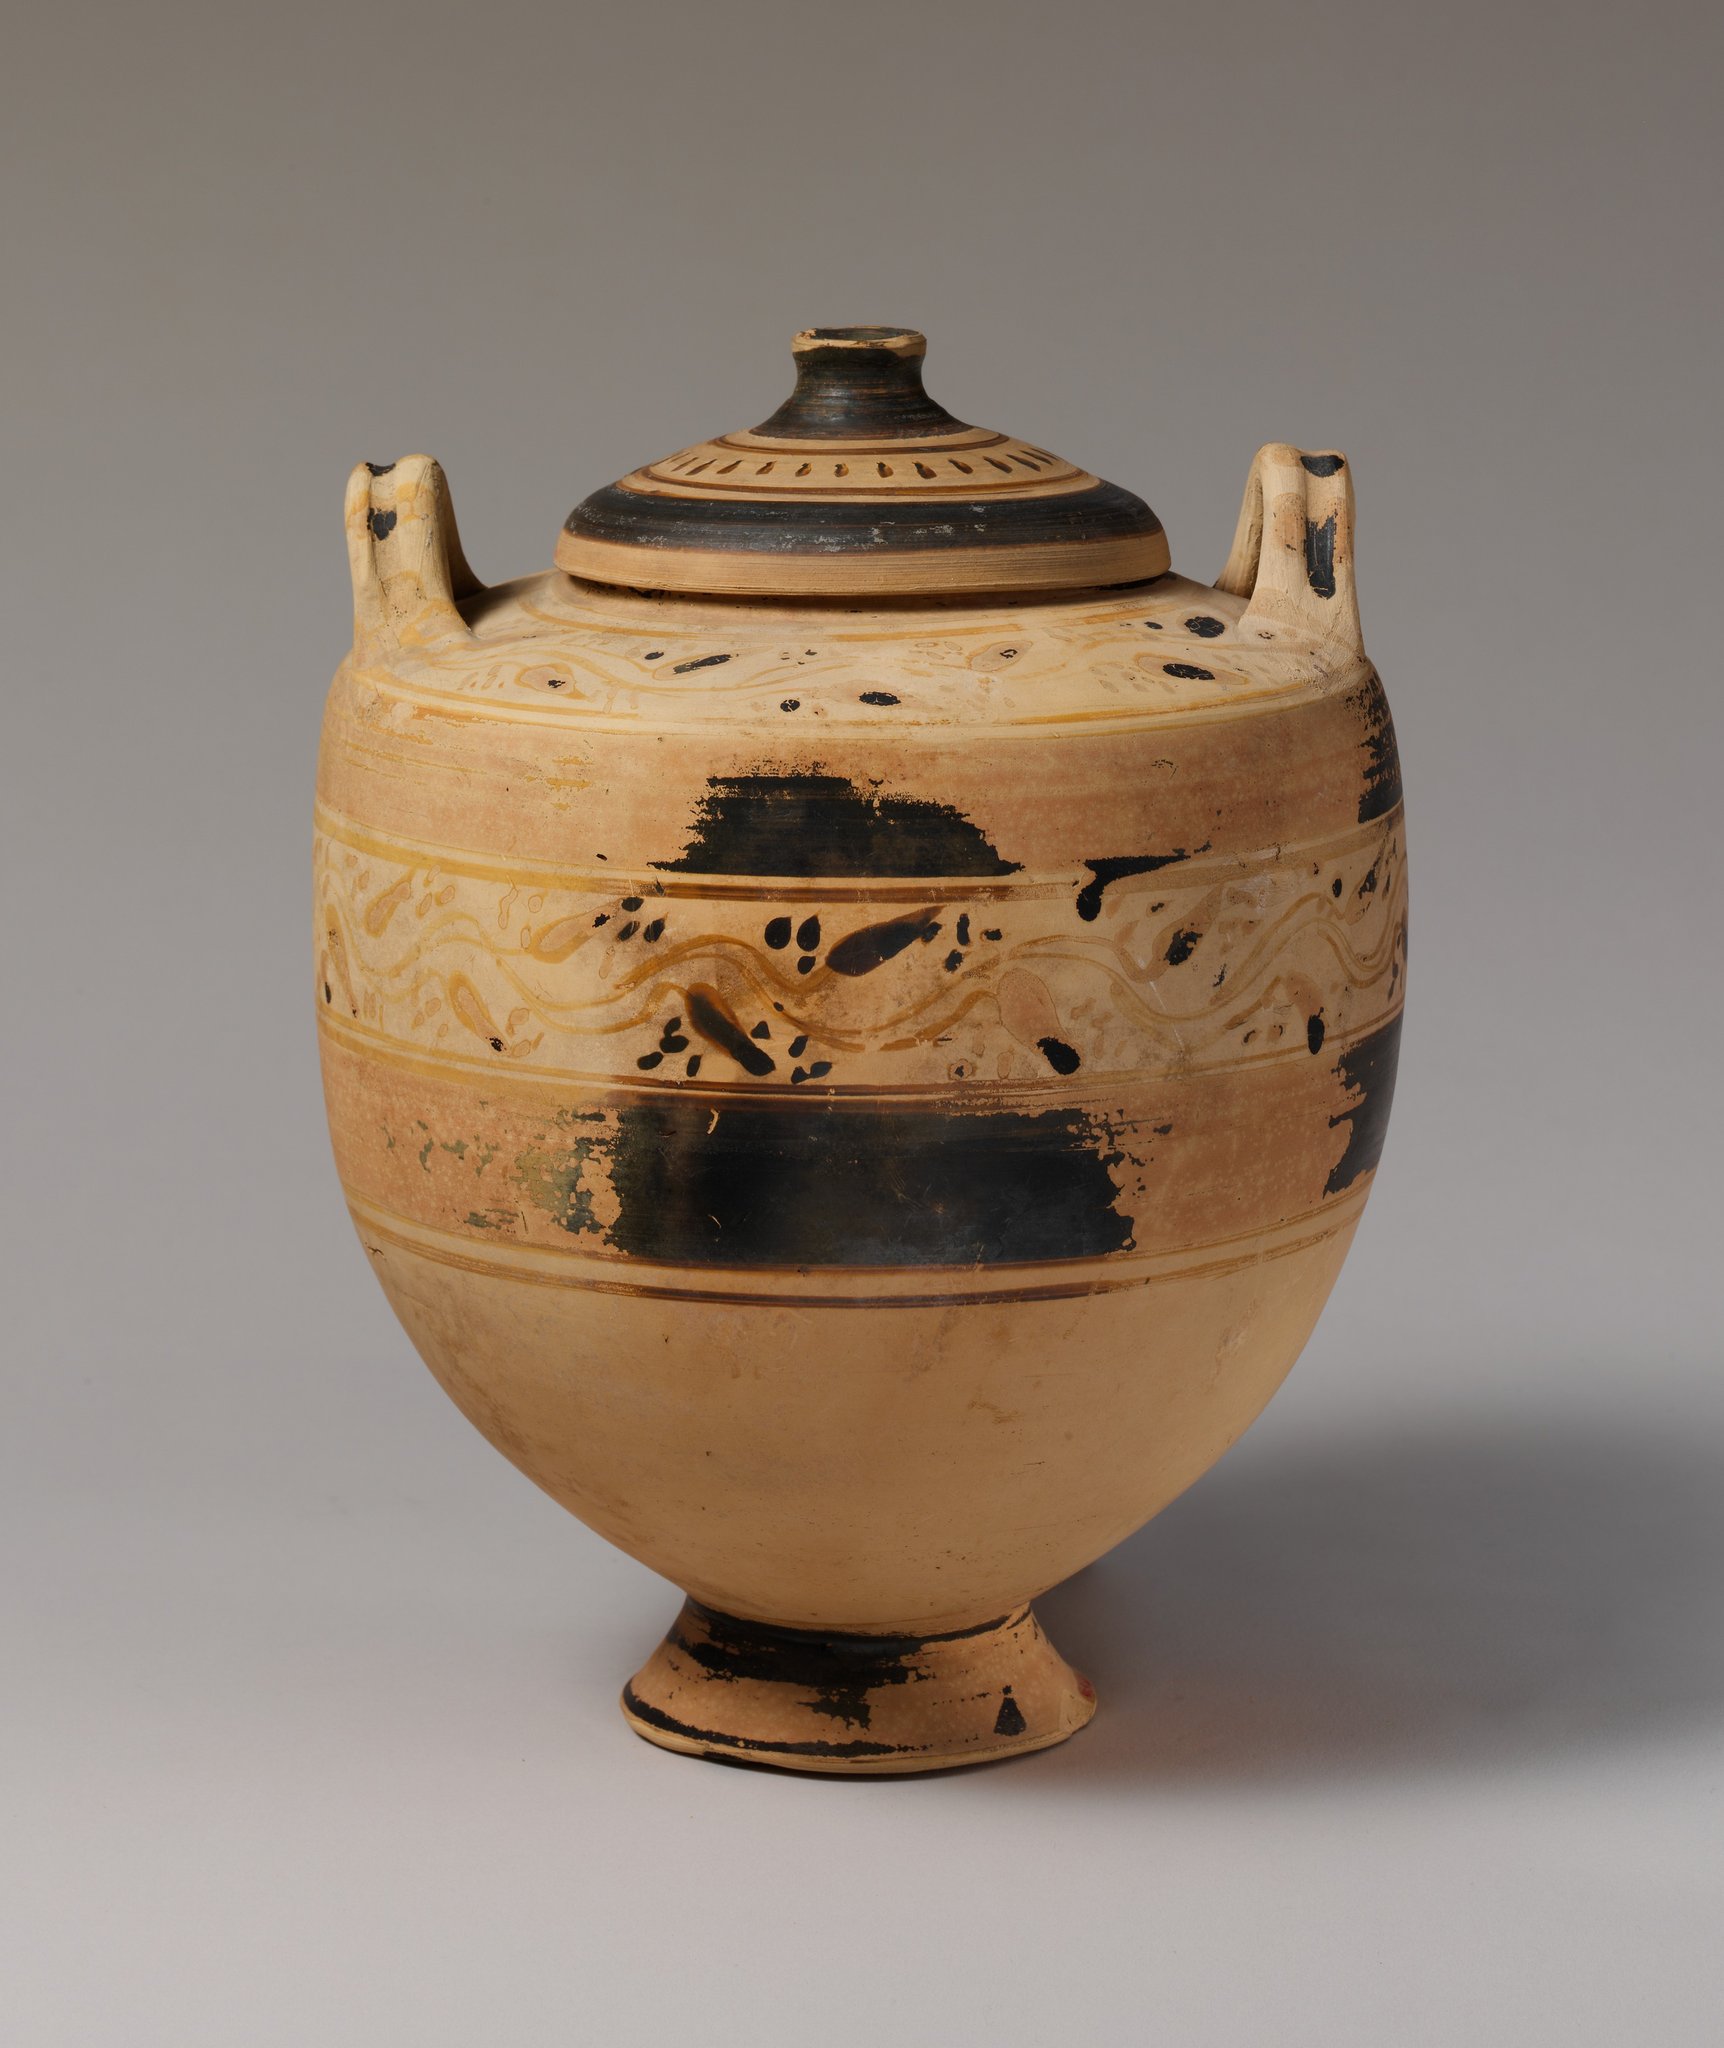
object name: lebes gamikos and lid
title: Terracotta lebes gamikos (jar) and lid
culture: greek, cretan or ptolemaic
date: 234-201 BCE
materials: terracotta